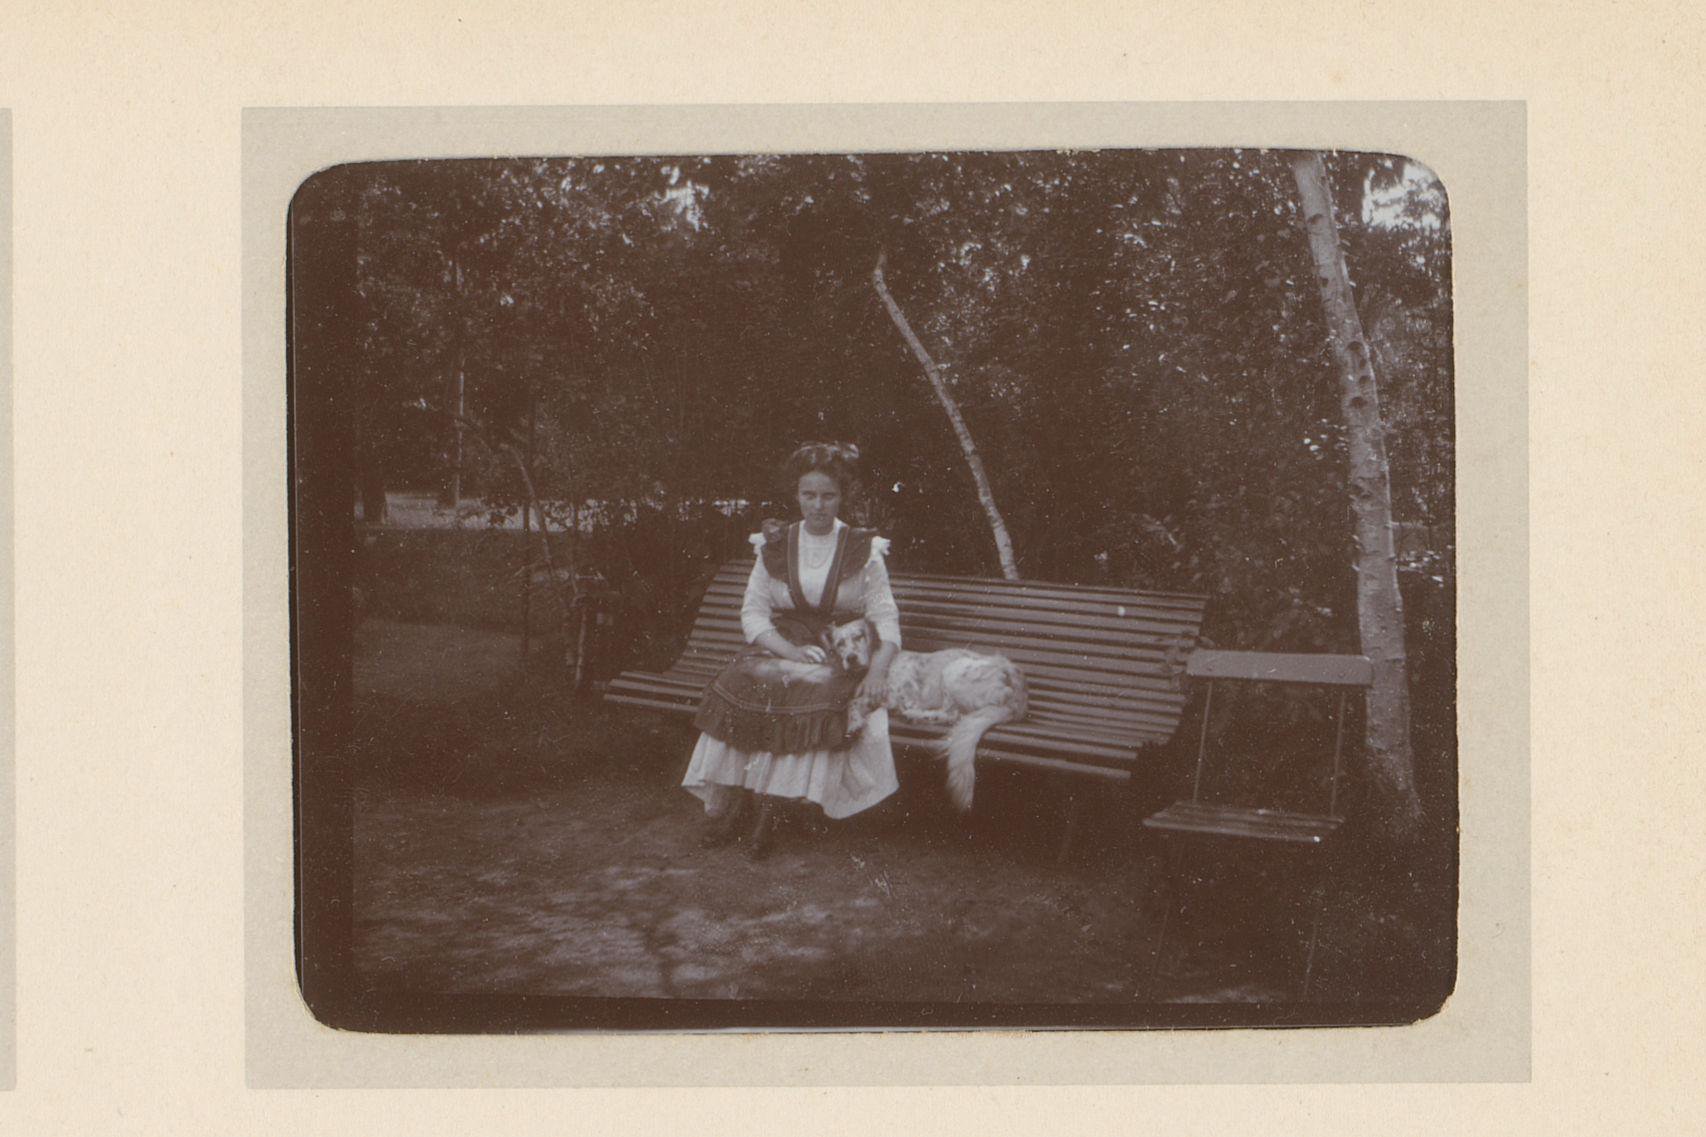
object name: photograph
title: Portret van een vrouw zittend op een bank met een hond in een tuin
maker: liesbeth overhoff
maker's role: fotograaf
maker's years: 1895-1969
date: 1911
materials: paper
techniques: collodion silver print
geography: baarn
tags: sitting figure, historical persons - bb - woman, garden, dog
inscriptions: inscription: ‘Baarn 1911’